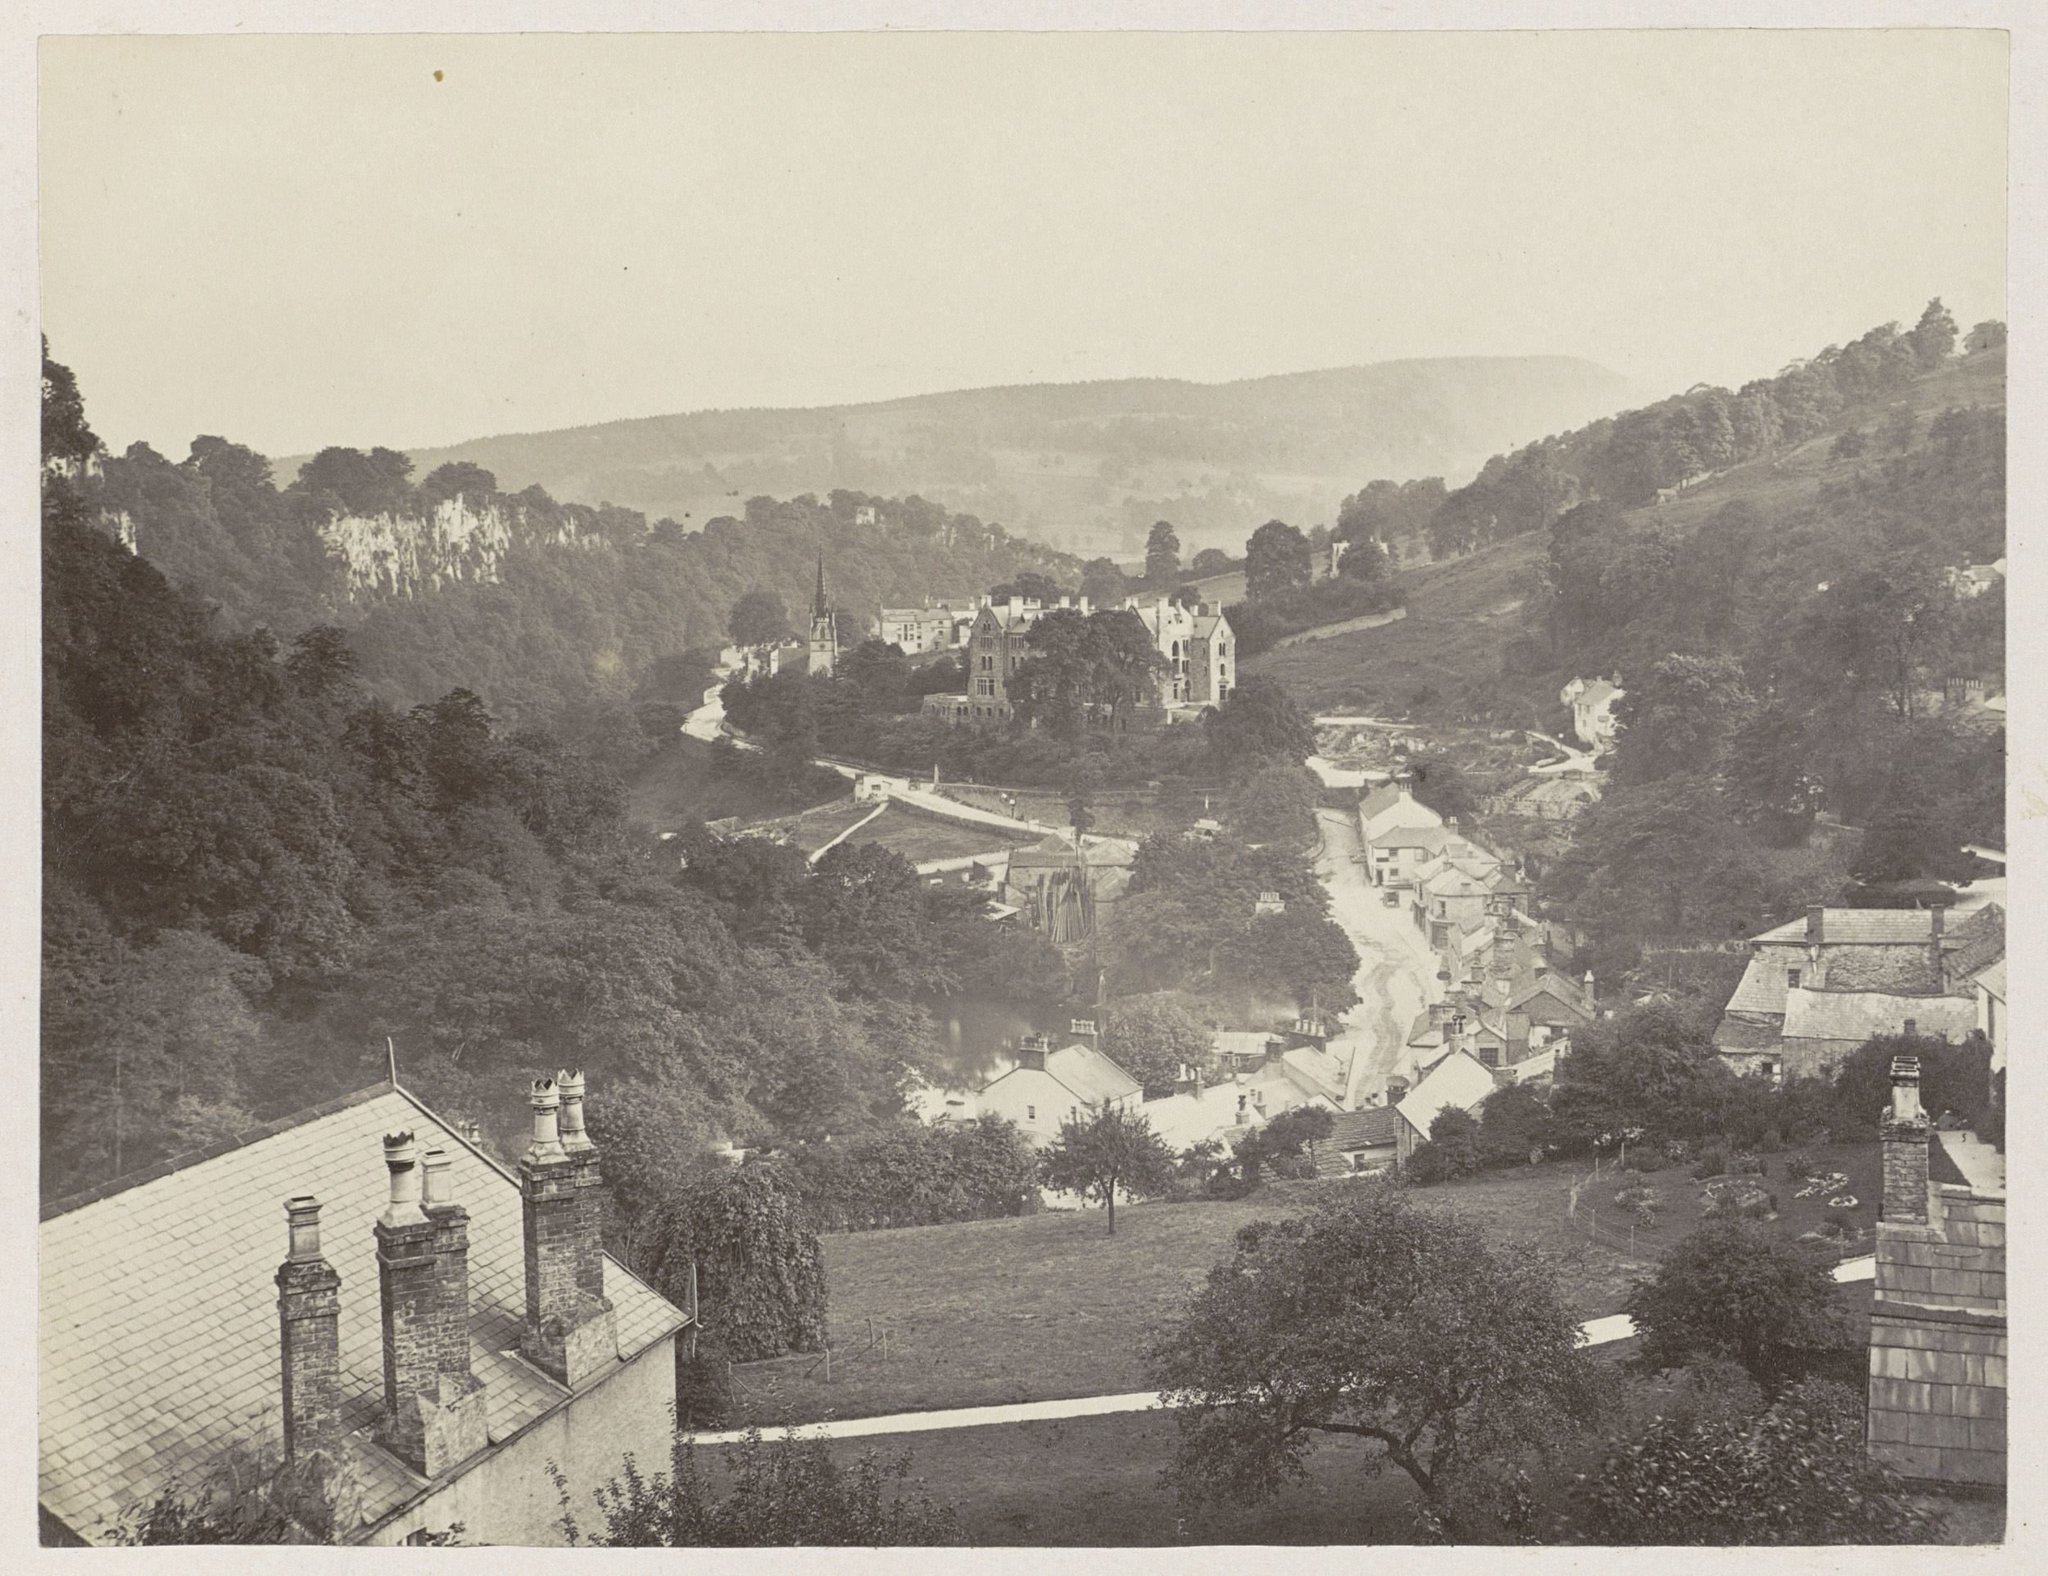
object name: photograph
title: Matlock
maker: Anonymous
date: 1878-1890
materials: photographic support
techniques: albumen print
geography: matlock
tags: prospect of village, silhouette of village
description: Onderdeel van Reisalbum Europese steden, vermoedelijk Zweeds.